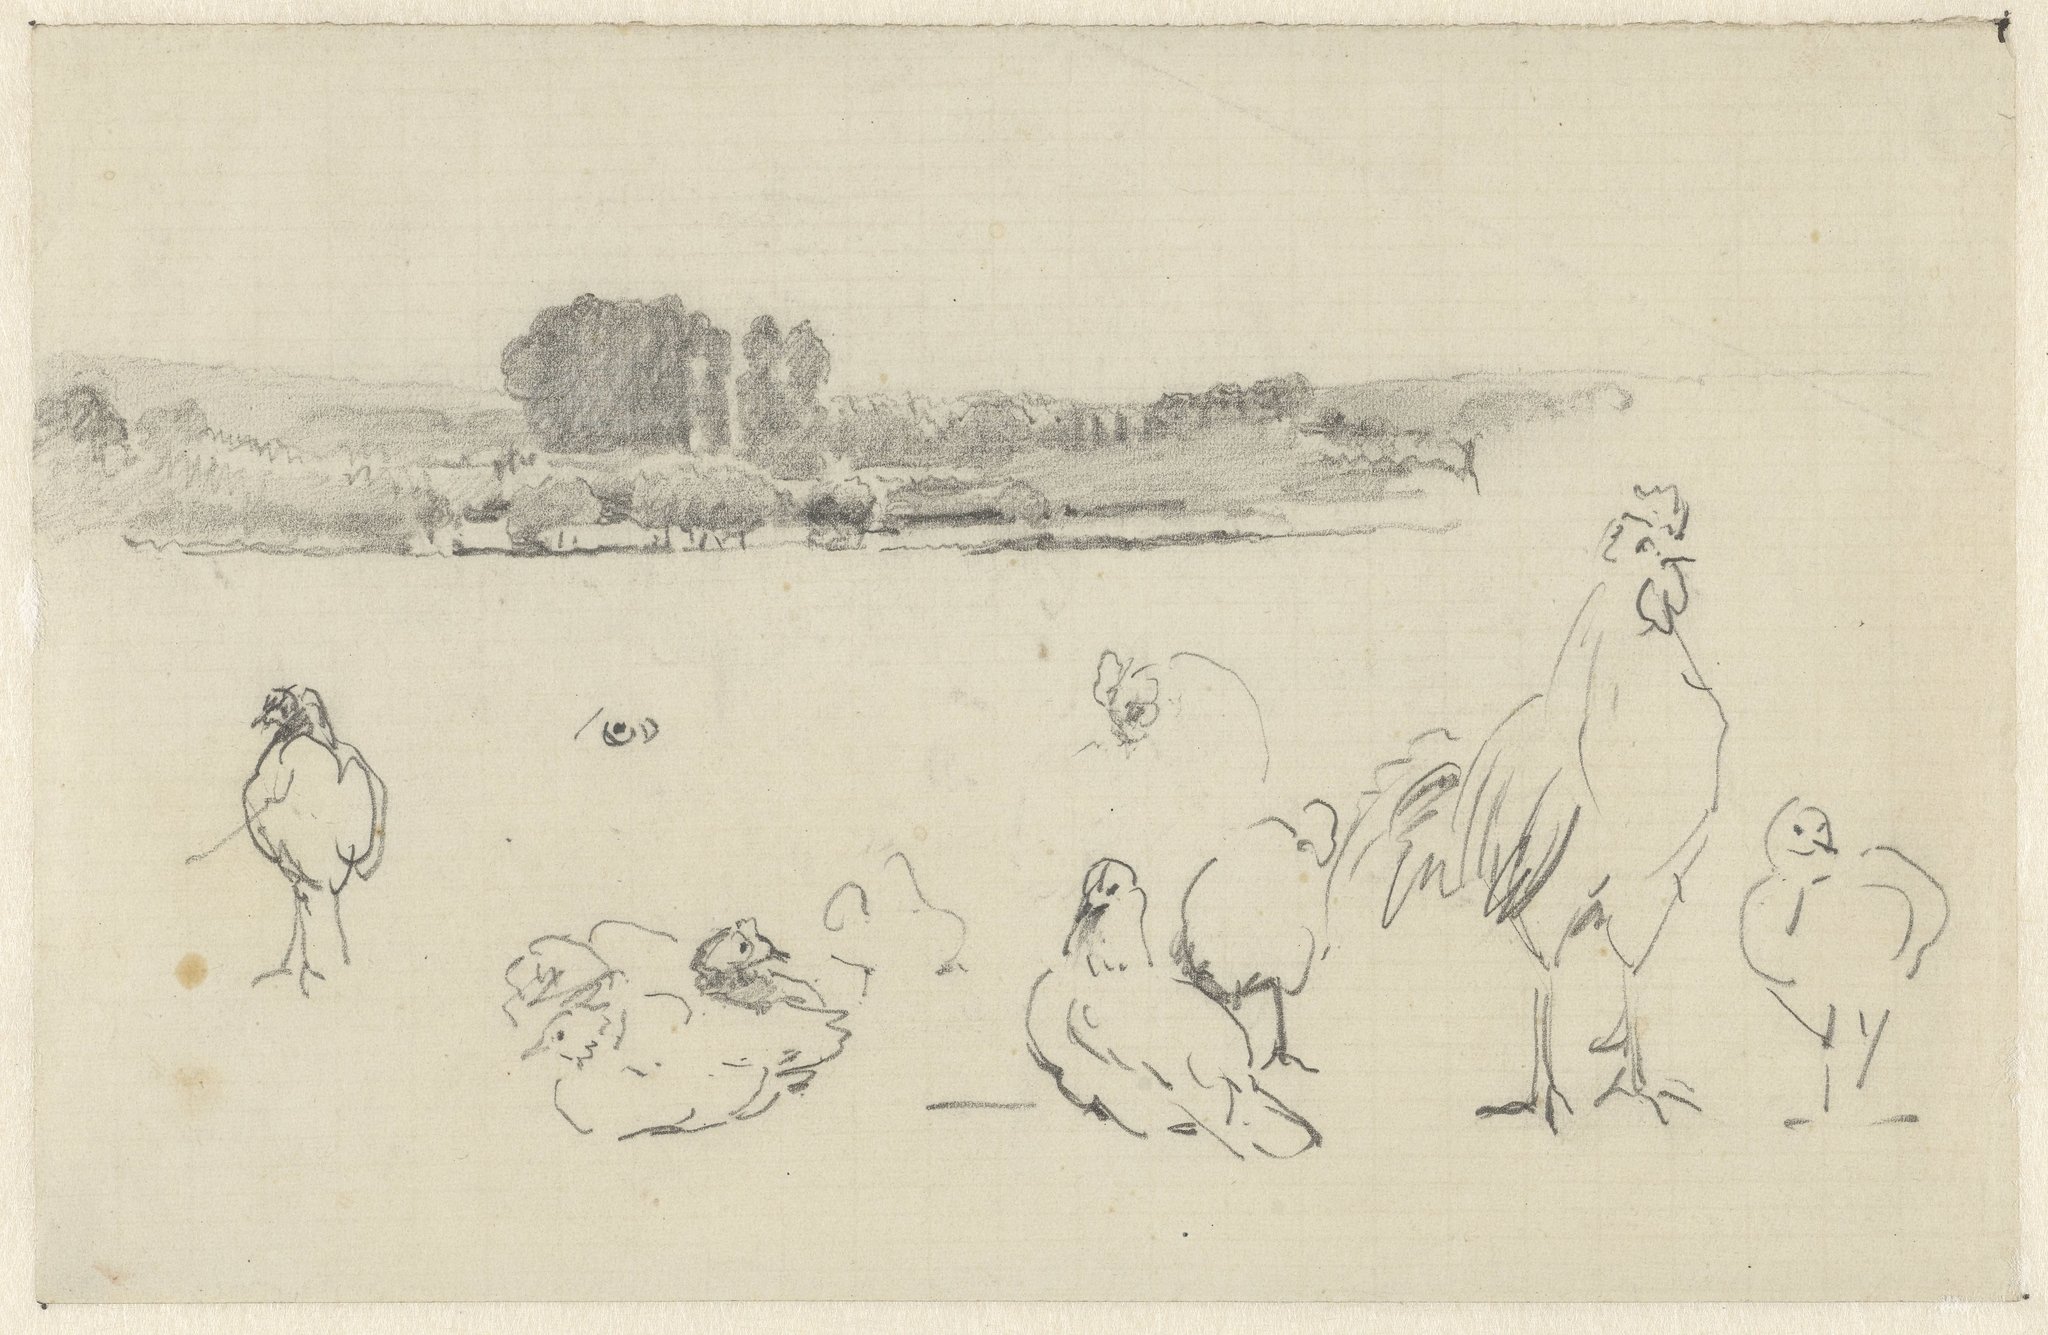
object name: drawing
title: Rivierlandschap en gevogelte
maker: guillaume anne van der brugghen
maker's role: draughtsman, print maker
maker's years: 1812-1891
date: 1821-1891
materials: paper, pencil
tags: fowl (cock, hen, chicken, etc.)